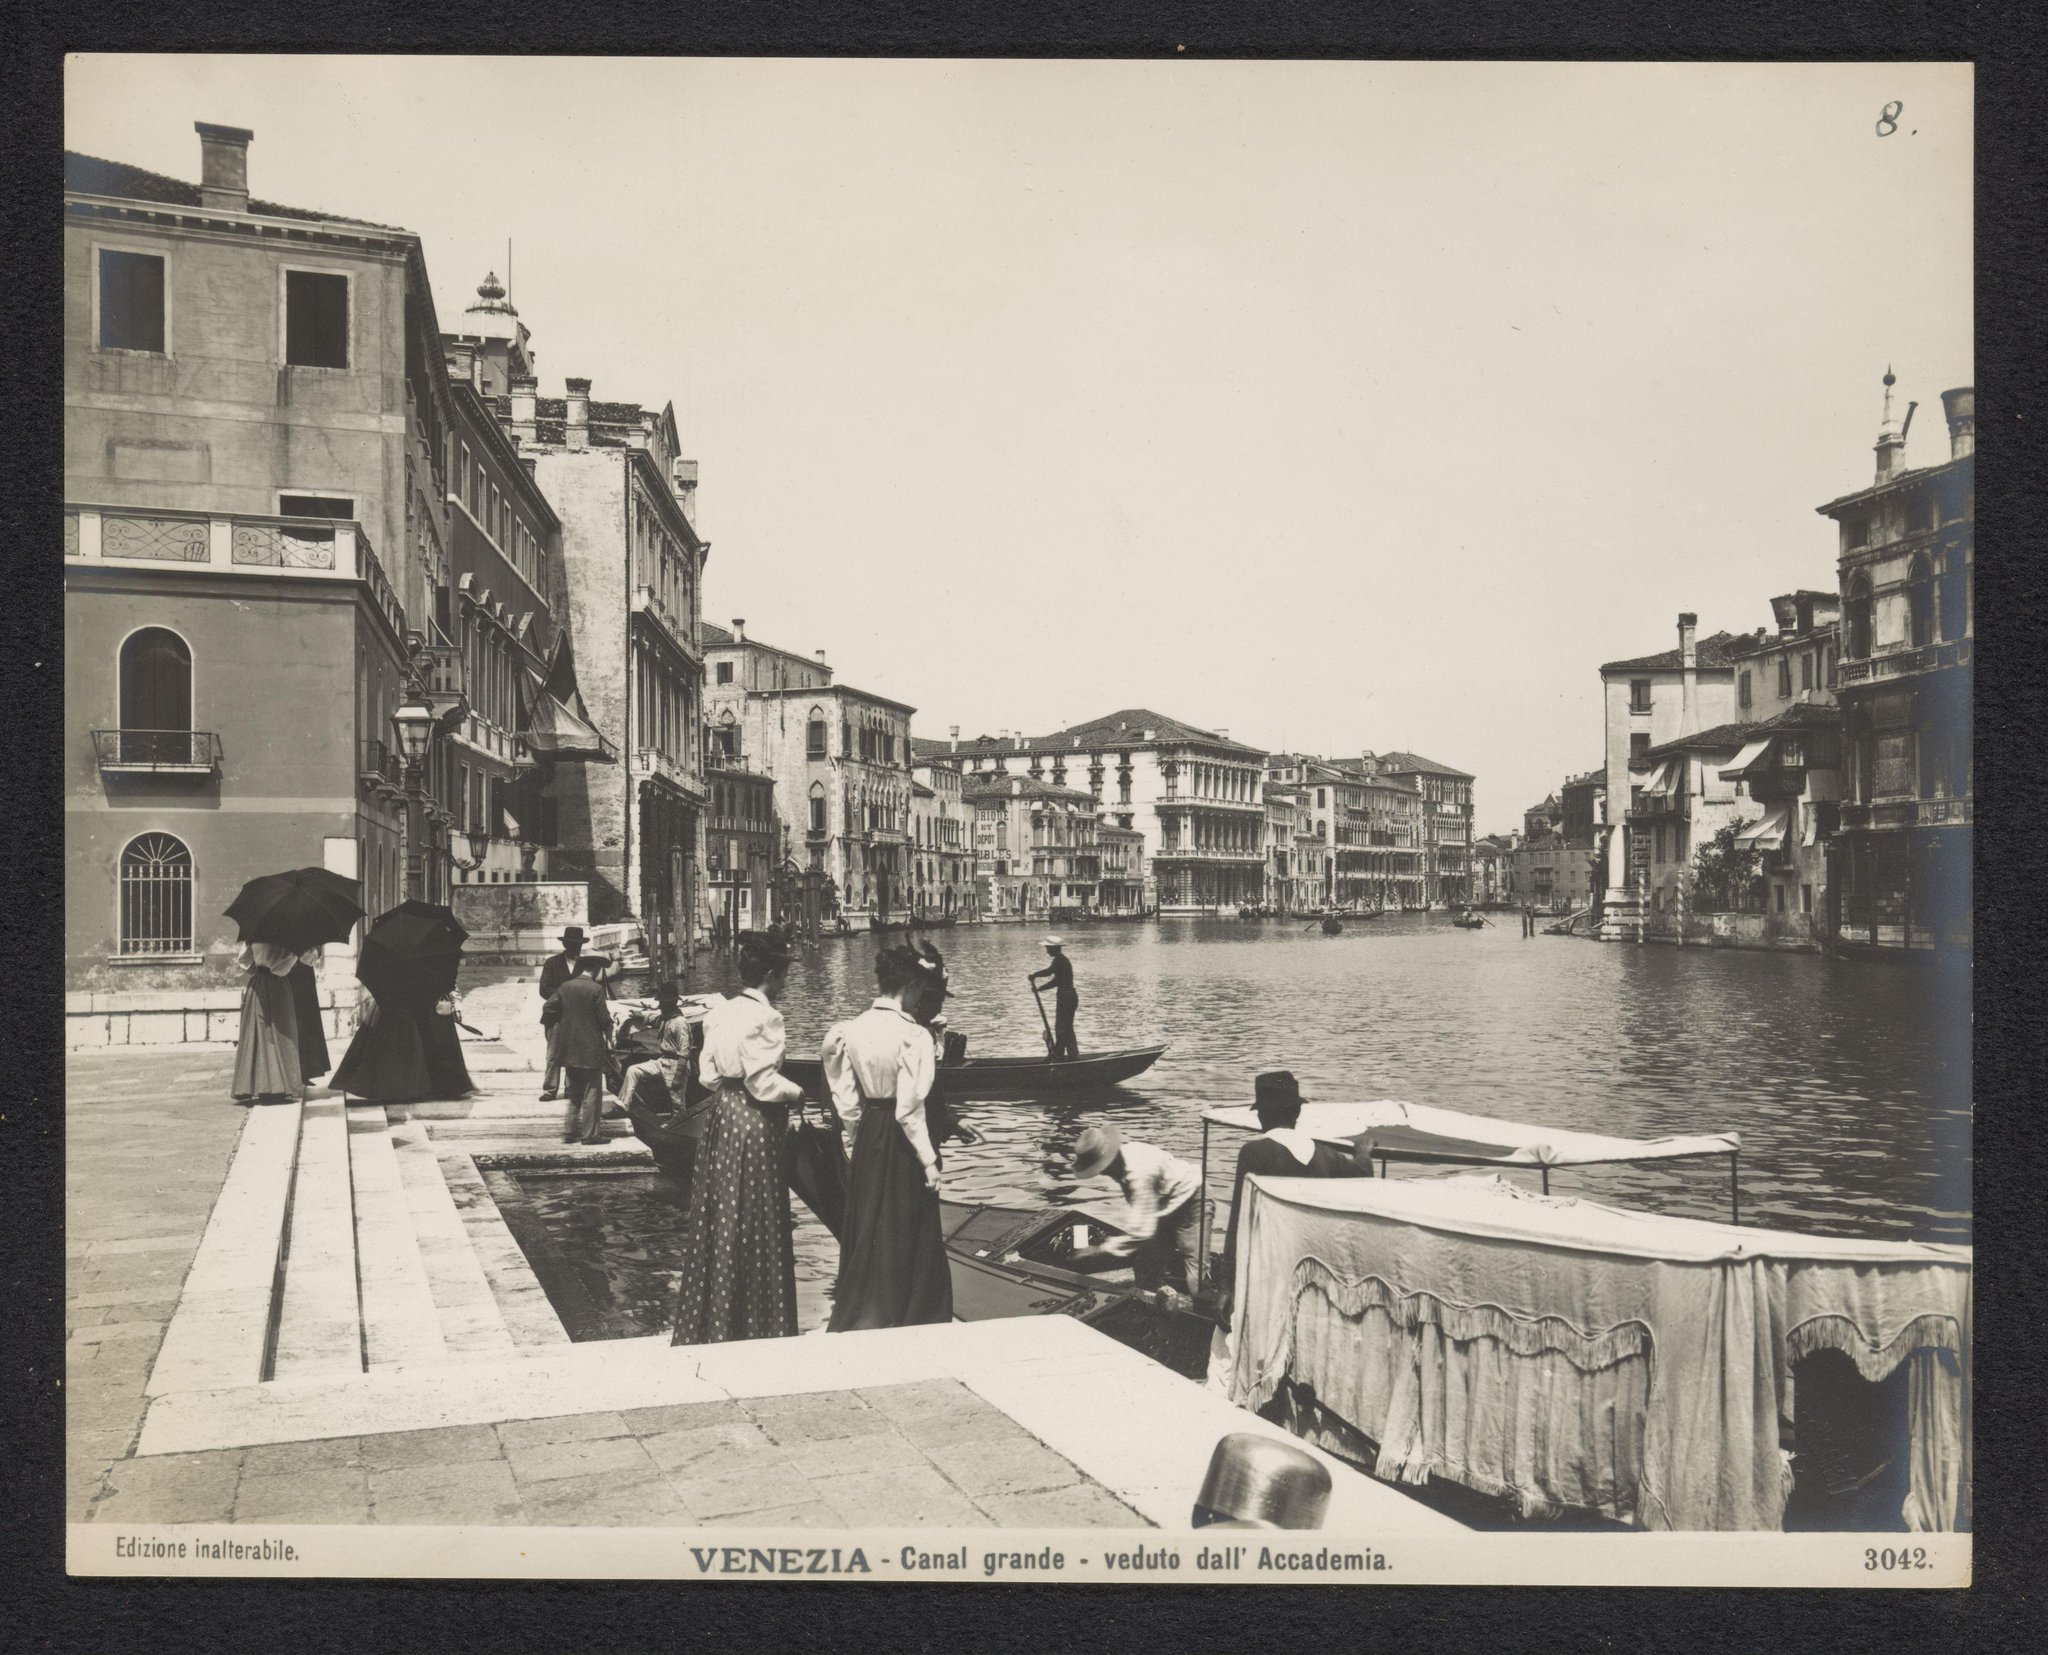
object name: photograph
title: Venezia - Canal grande - veduto dall'Accademia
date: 1900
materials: cardboard, photographic support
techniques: gelatin silver print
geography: venice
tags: canal, façade (of house or building), gondola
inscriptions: number: ‘3042.’, number: ‘8.’